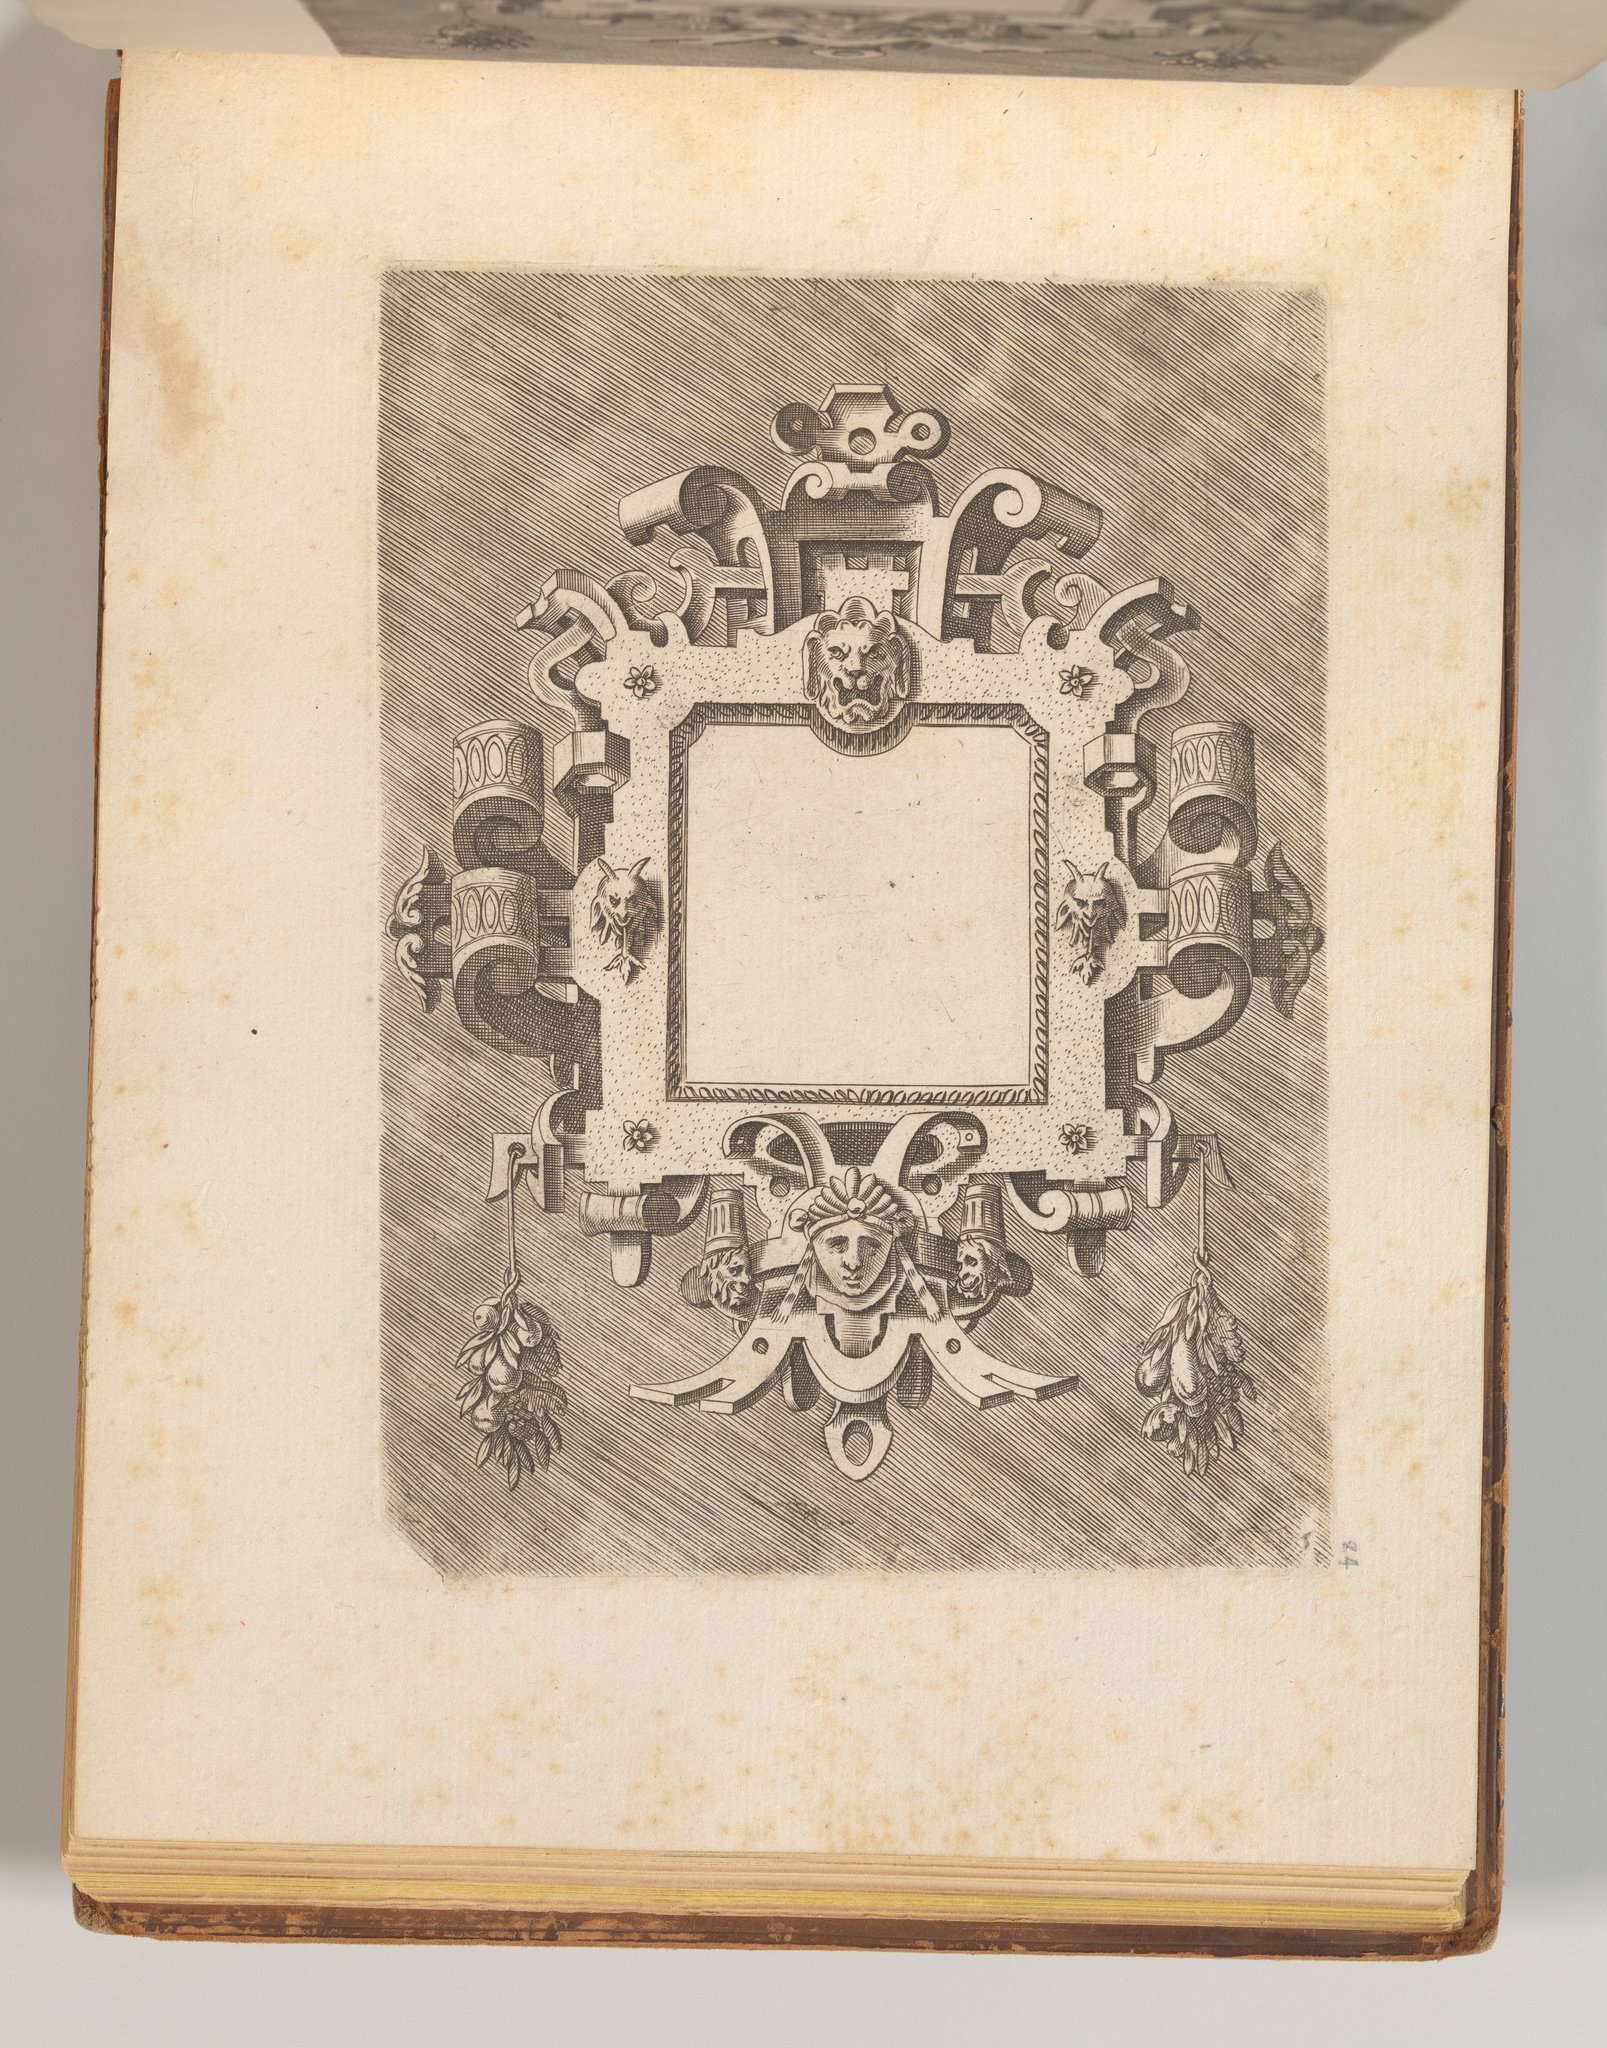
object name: album print ornament architecture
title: Targhe ed altri ornati di varie e capricciose invenzioni (Cartouches and other ornaments of various and capricious invention, page 31)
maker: hans vredeman de vries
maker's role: artist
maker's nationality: netherlandish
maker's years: 1527-1606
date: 1773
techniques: engraving, etching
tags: cartouches,ornament